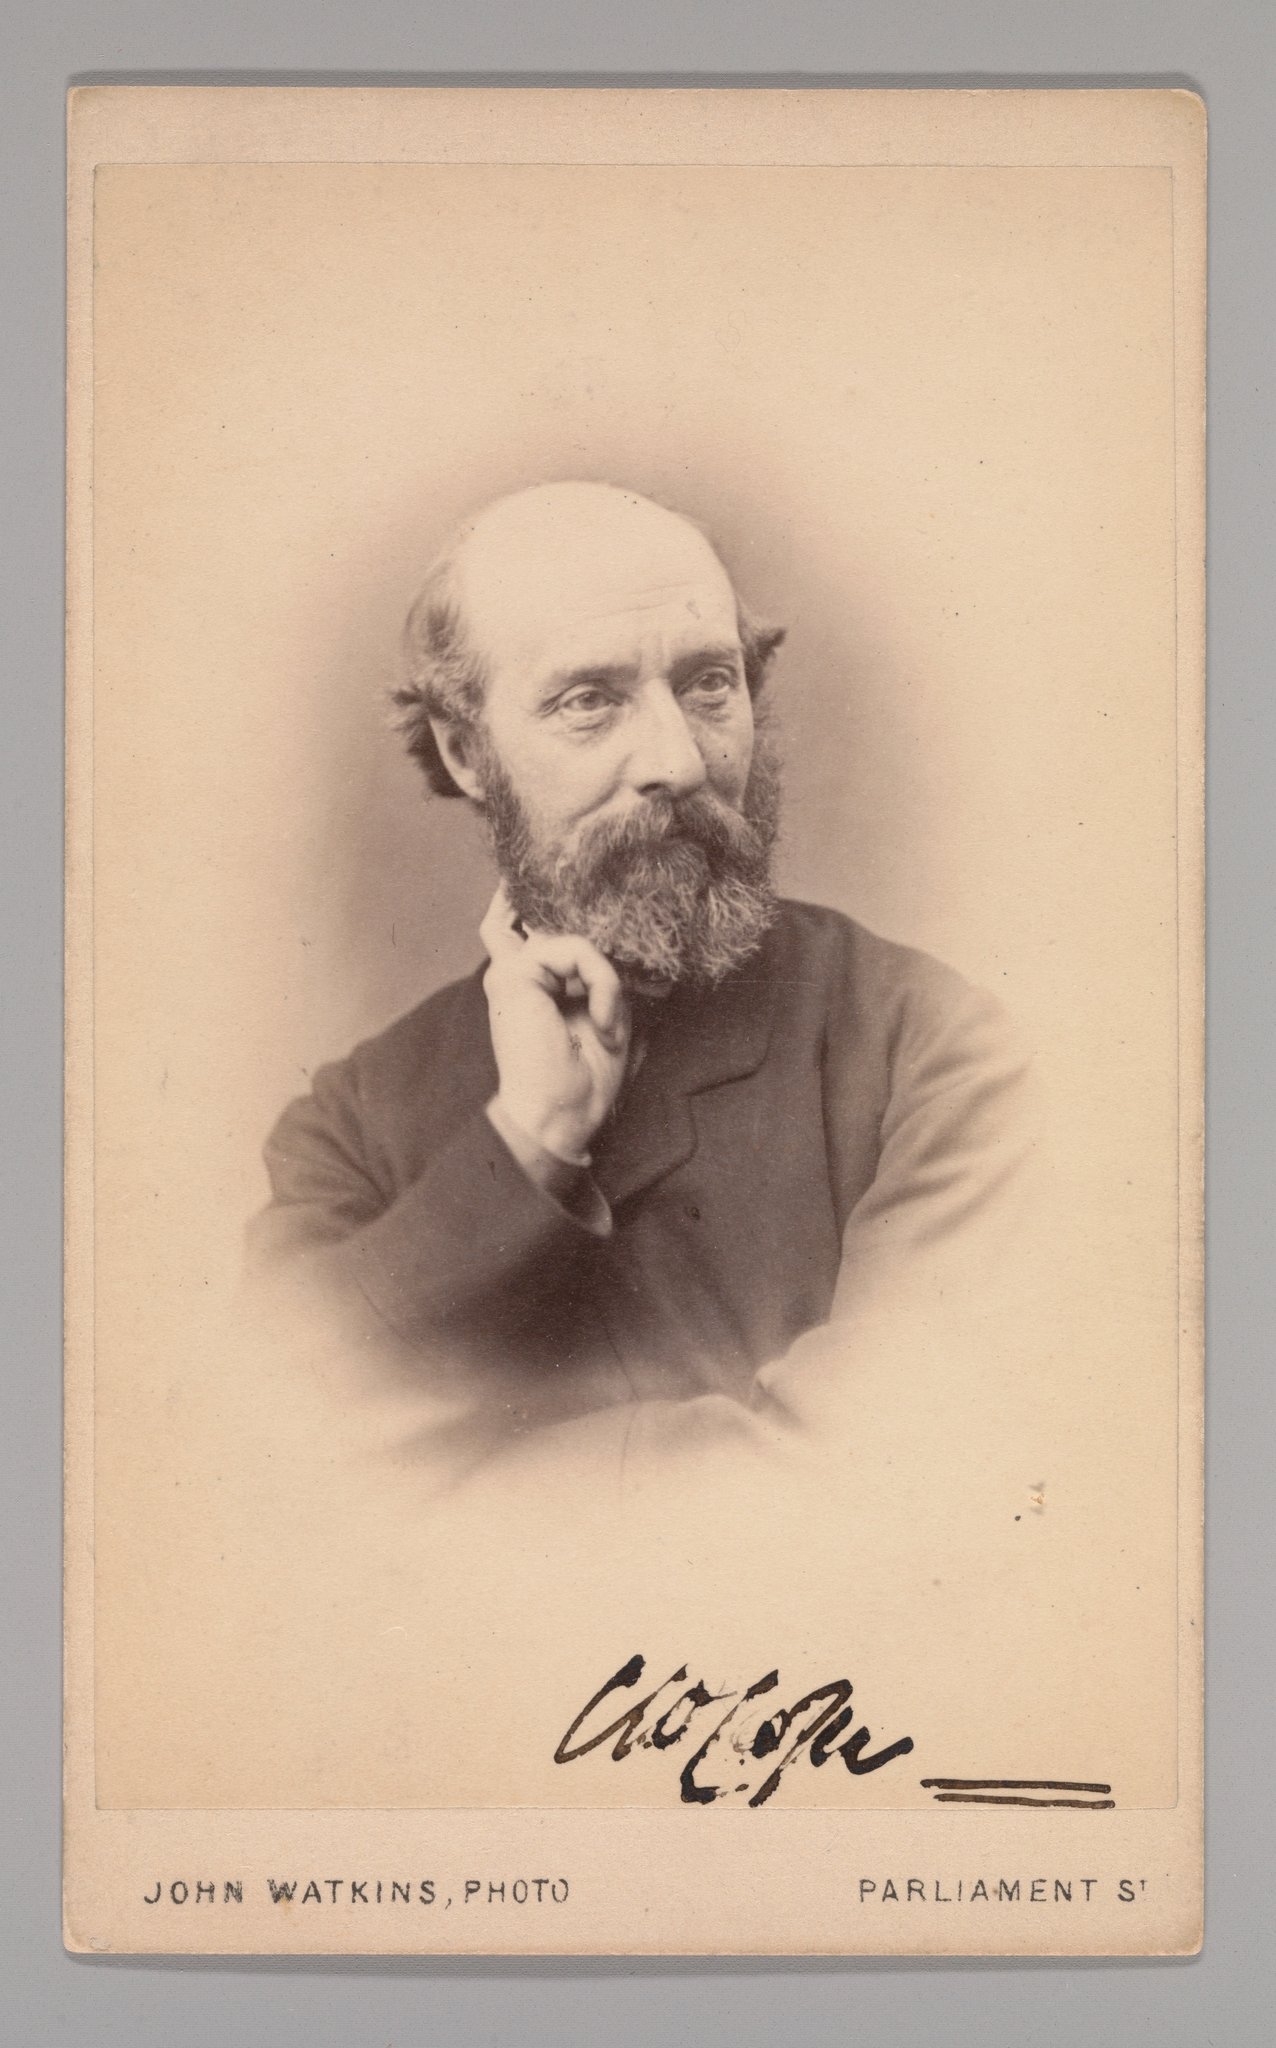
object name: carte de visite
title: [Charles West Cope]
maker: john and charles watkins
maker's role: photography studio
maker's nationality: british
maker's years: 1840-1875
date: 1860-1869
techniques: albumen silver print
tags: men,portraits